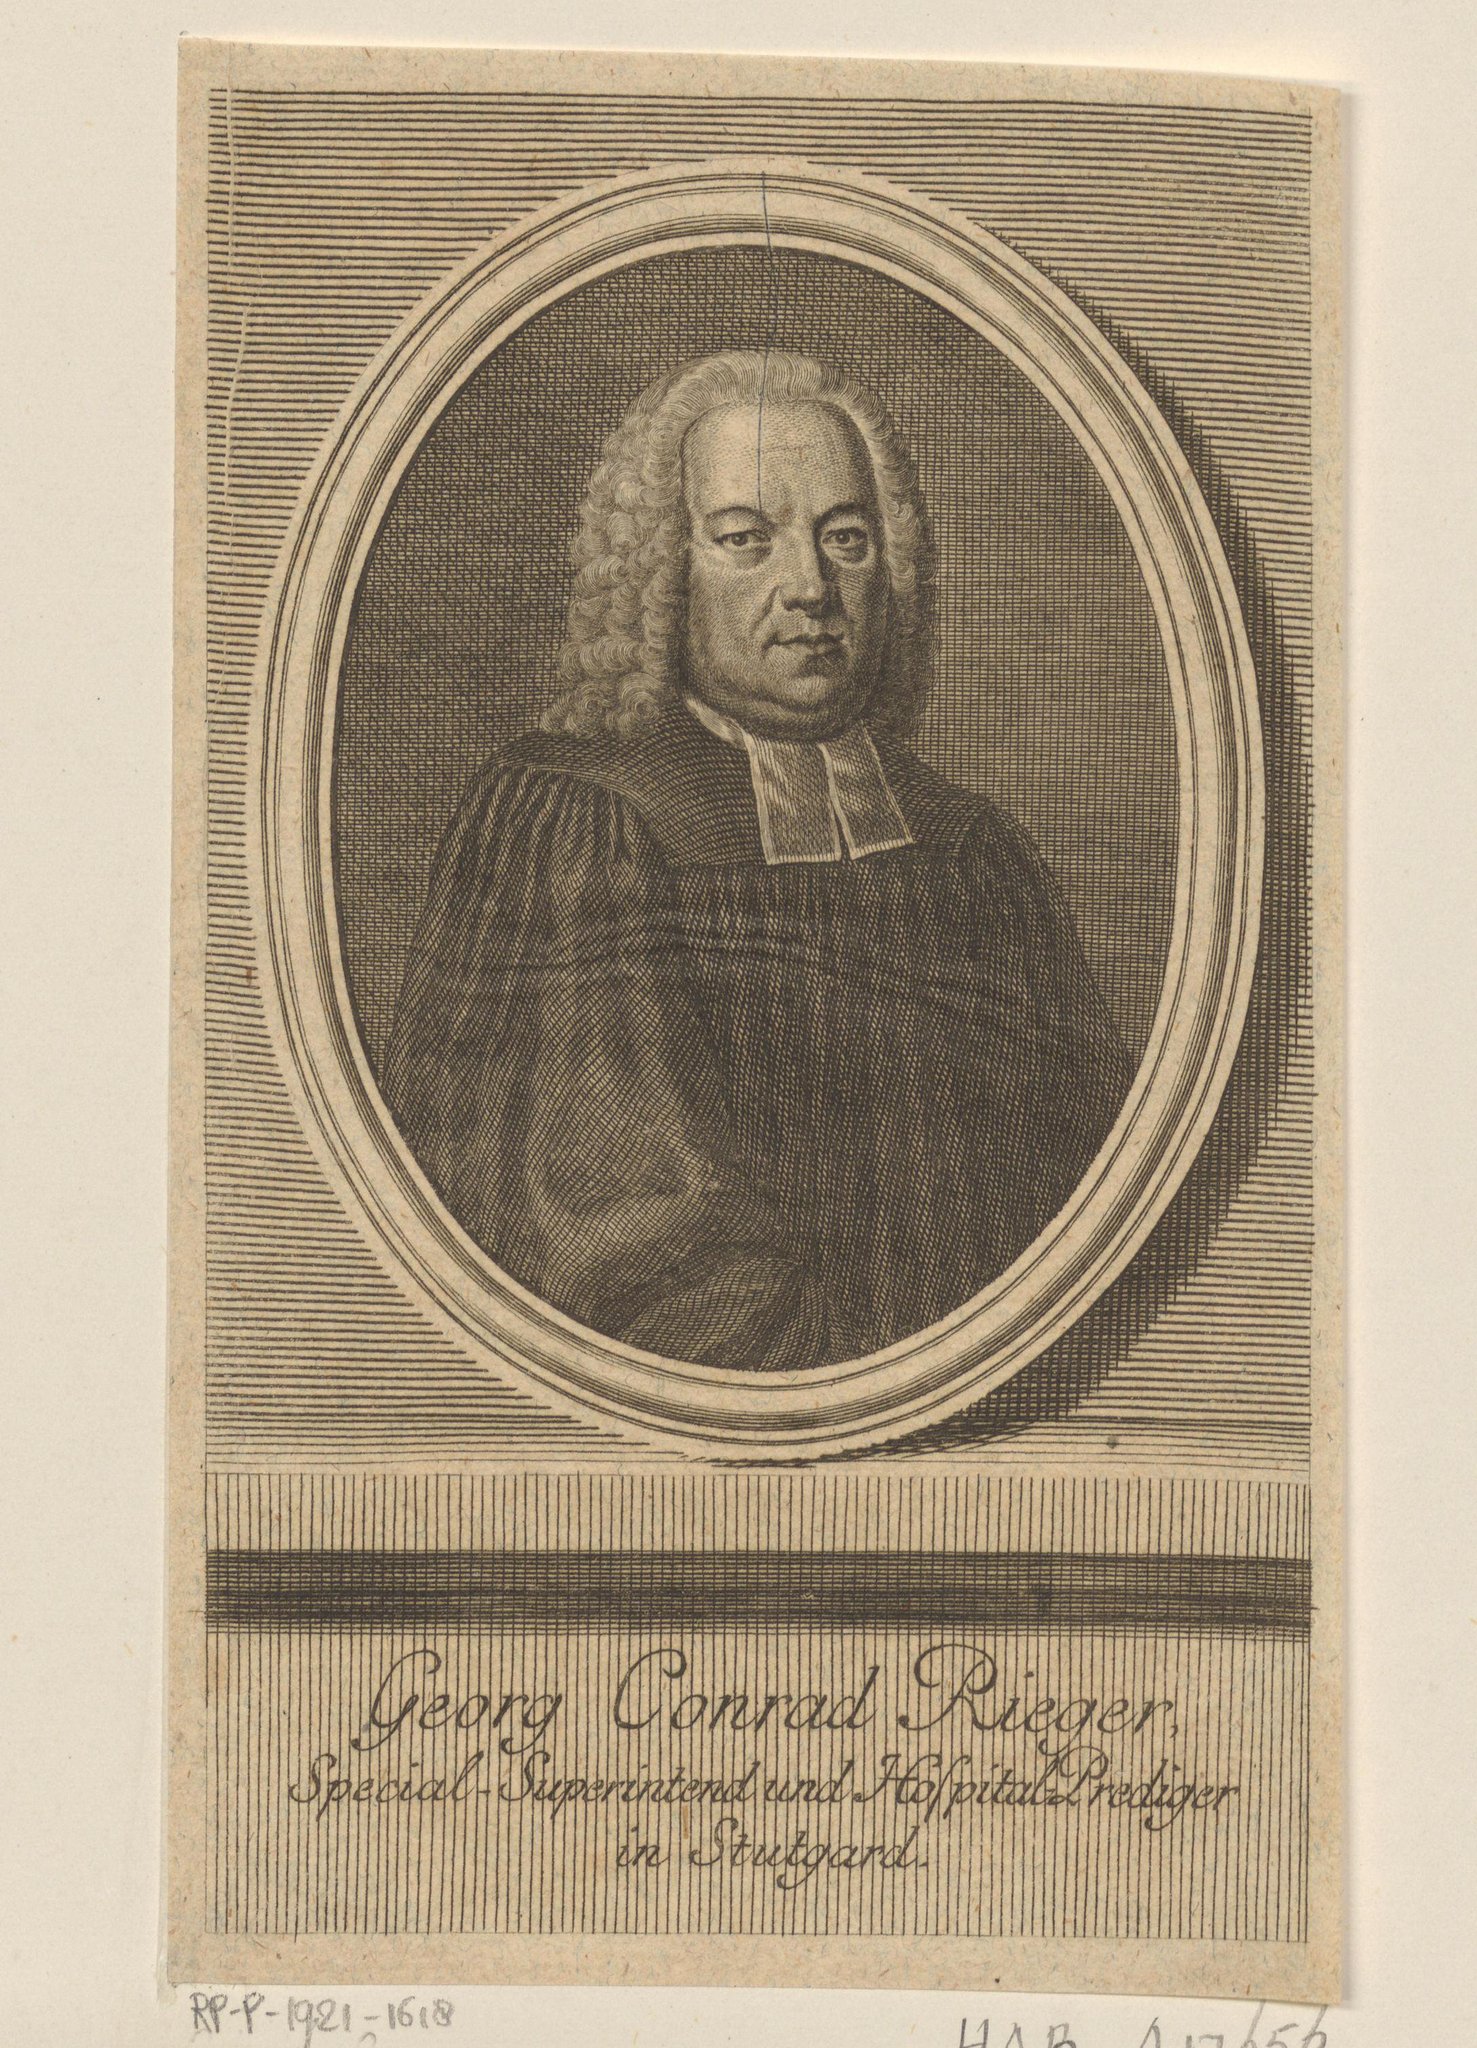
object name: print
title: Portret van Georg Conrad Rieger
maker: johann martin bernigeroth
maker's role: print maker, publisher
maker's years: 1713-1767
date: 1748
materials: paper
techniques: engraving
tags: historical persons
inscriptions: collector's mark: Lugt 2233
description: Prent waarschijnlijk uit: Zuverläßige Nachrichten von dem gegenwärtigen Zustande, Veränderung und Wachsthum der Wissenschaften. Leipzig: Johann Friedrich Gleditsch, 1748, dl. 98.